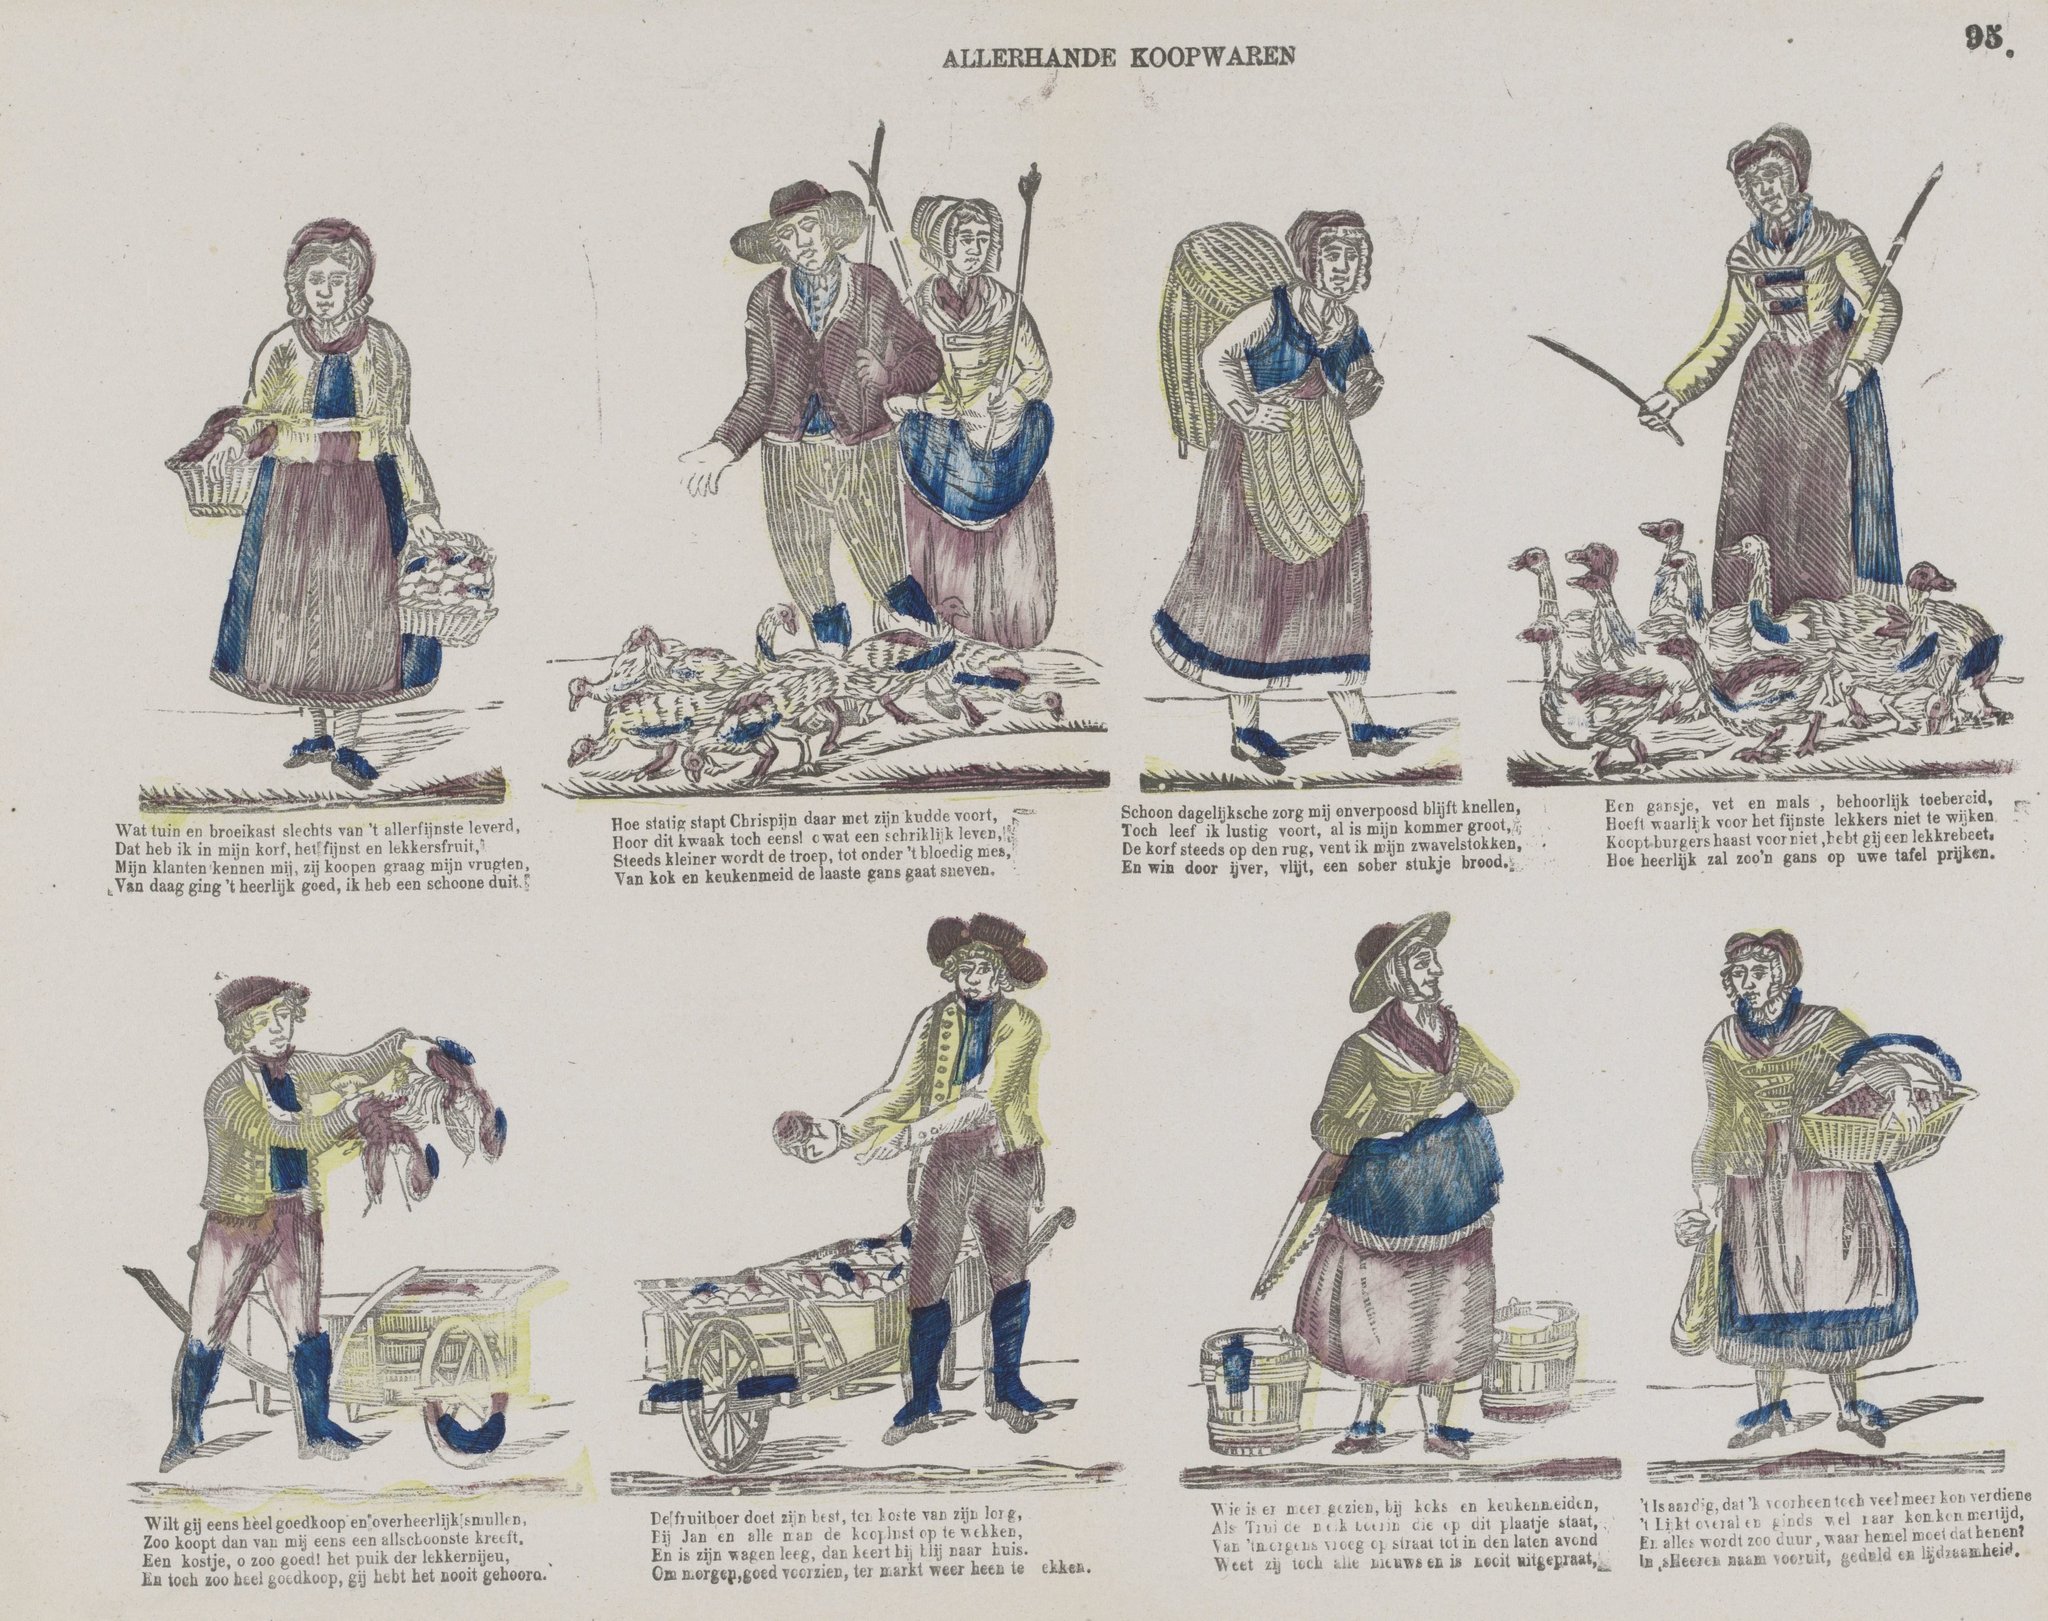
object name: print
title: Allerhande koopwaren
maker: Anonymous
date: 1848-1881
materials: paper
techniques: colour, letterpress printing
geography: den bosch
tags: street-trader, merchant, salesman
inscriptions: collector's mark: Lugt 2760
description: Blad met 8 voorstellingen van straatverkopers. Onder elke afbeelding een vierregelig vers. Rechtsboven genummerd: 95.